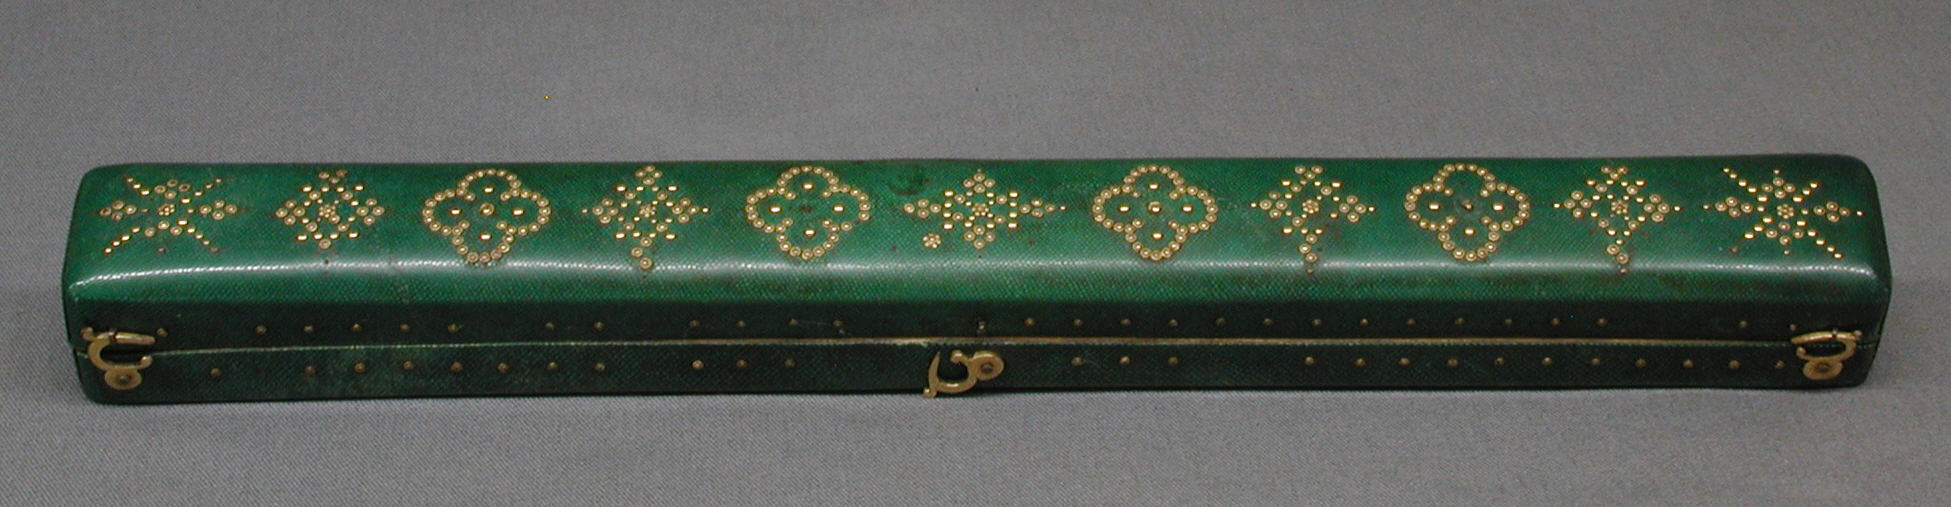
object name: fan box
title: Fan case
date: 1734-1766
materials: copper gilt, velvet, wood